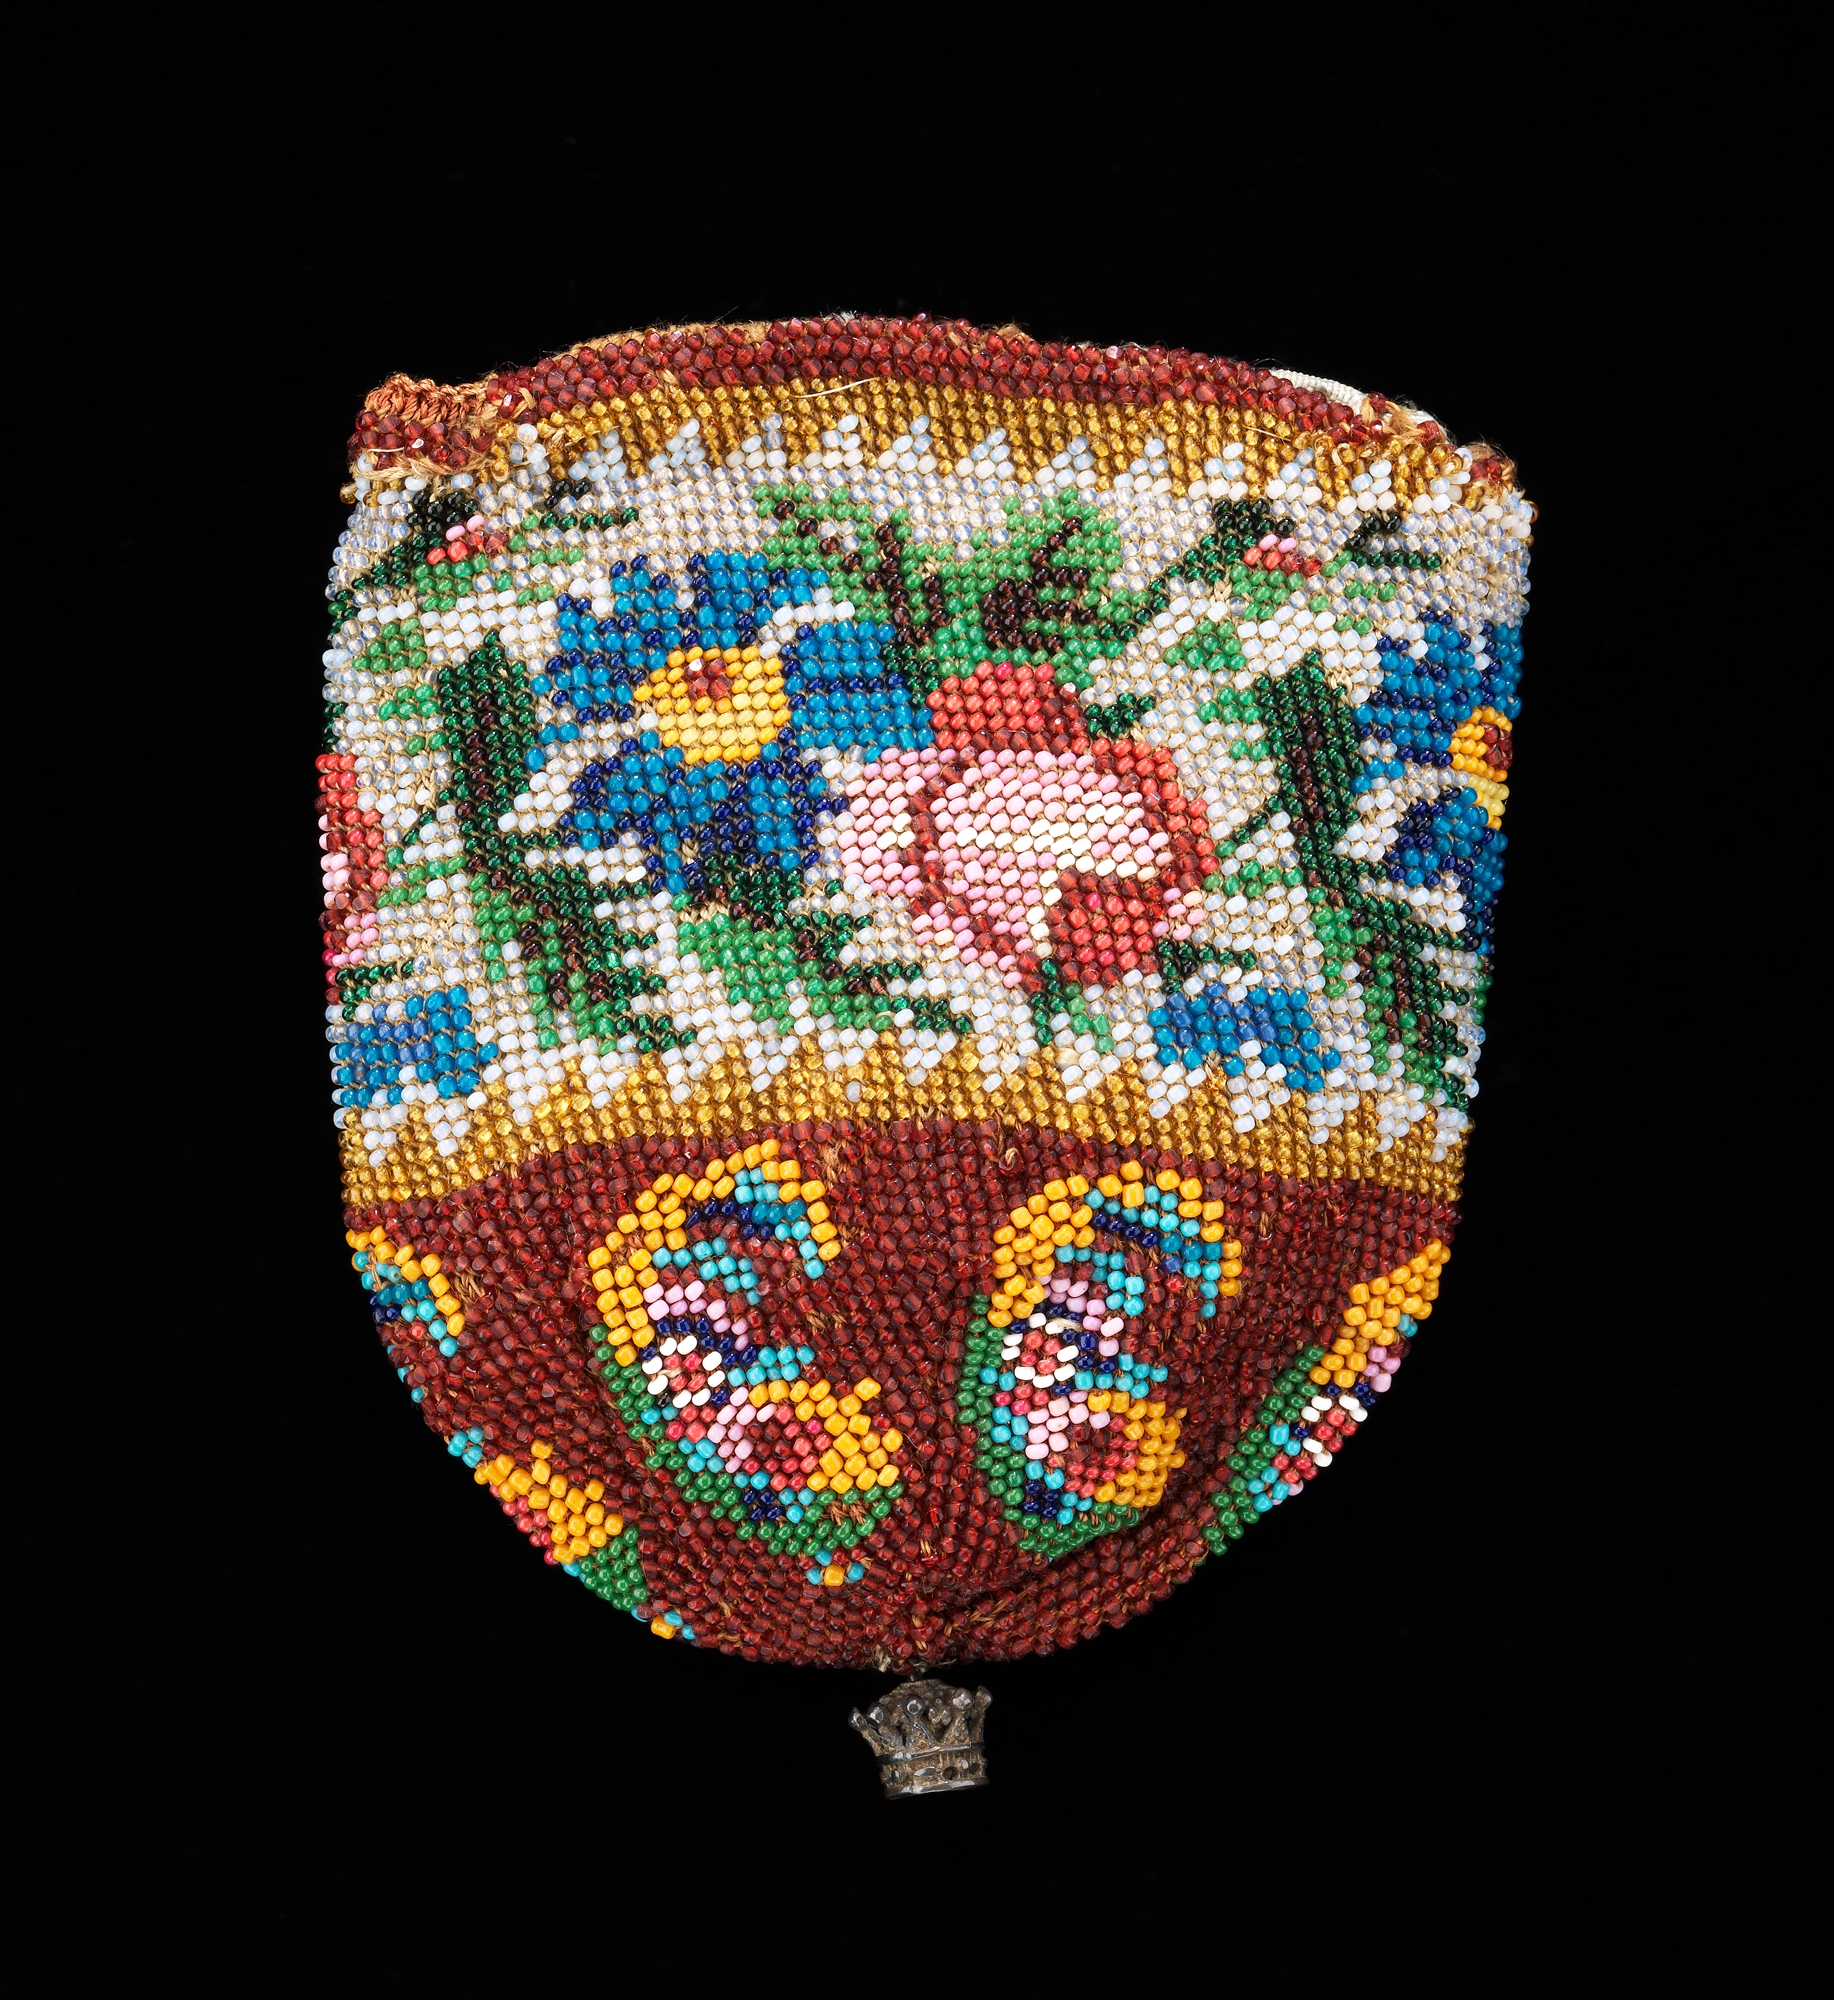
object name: coin purse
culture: american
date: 1830-1860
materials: glass, linen, metal, silk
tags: flowers